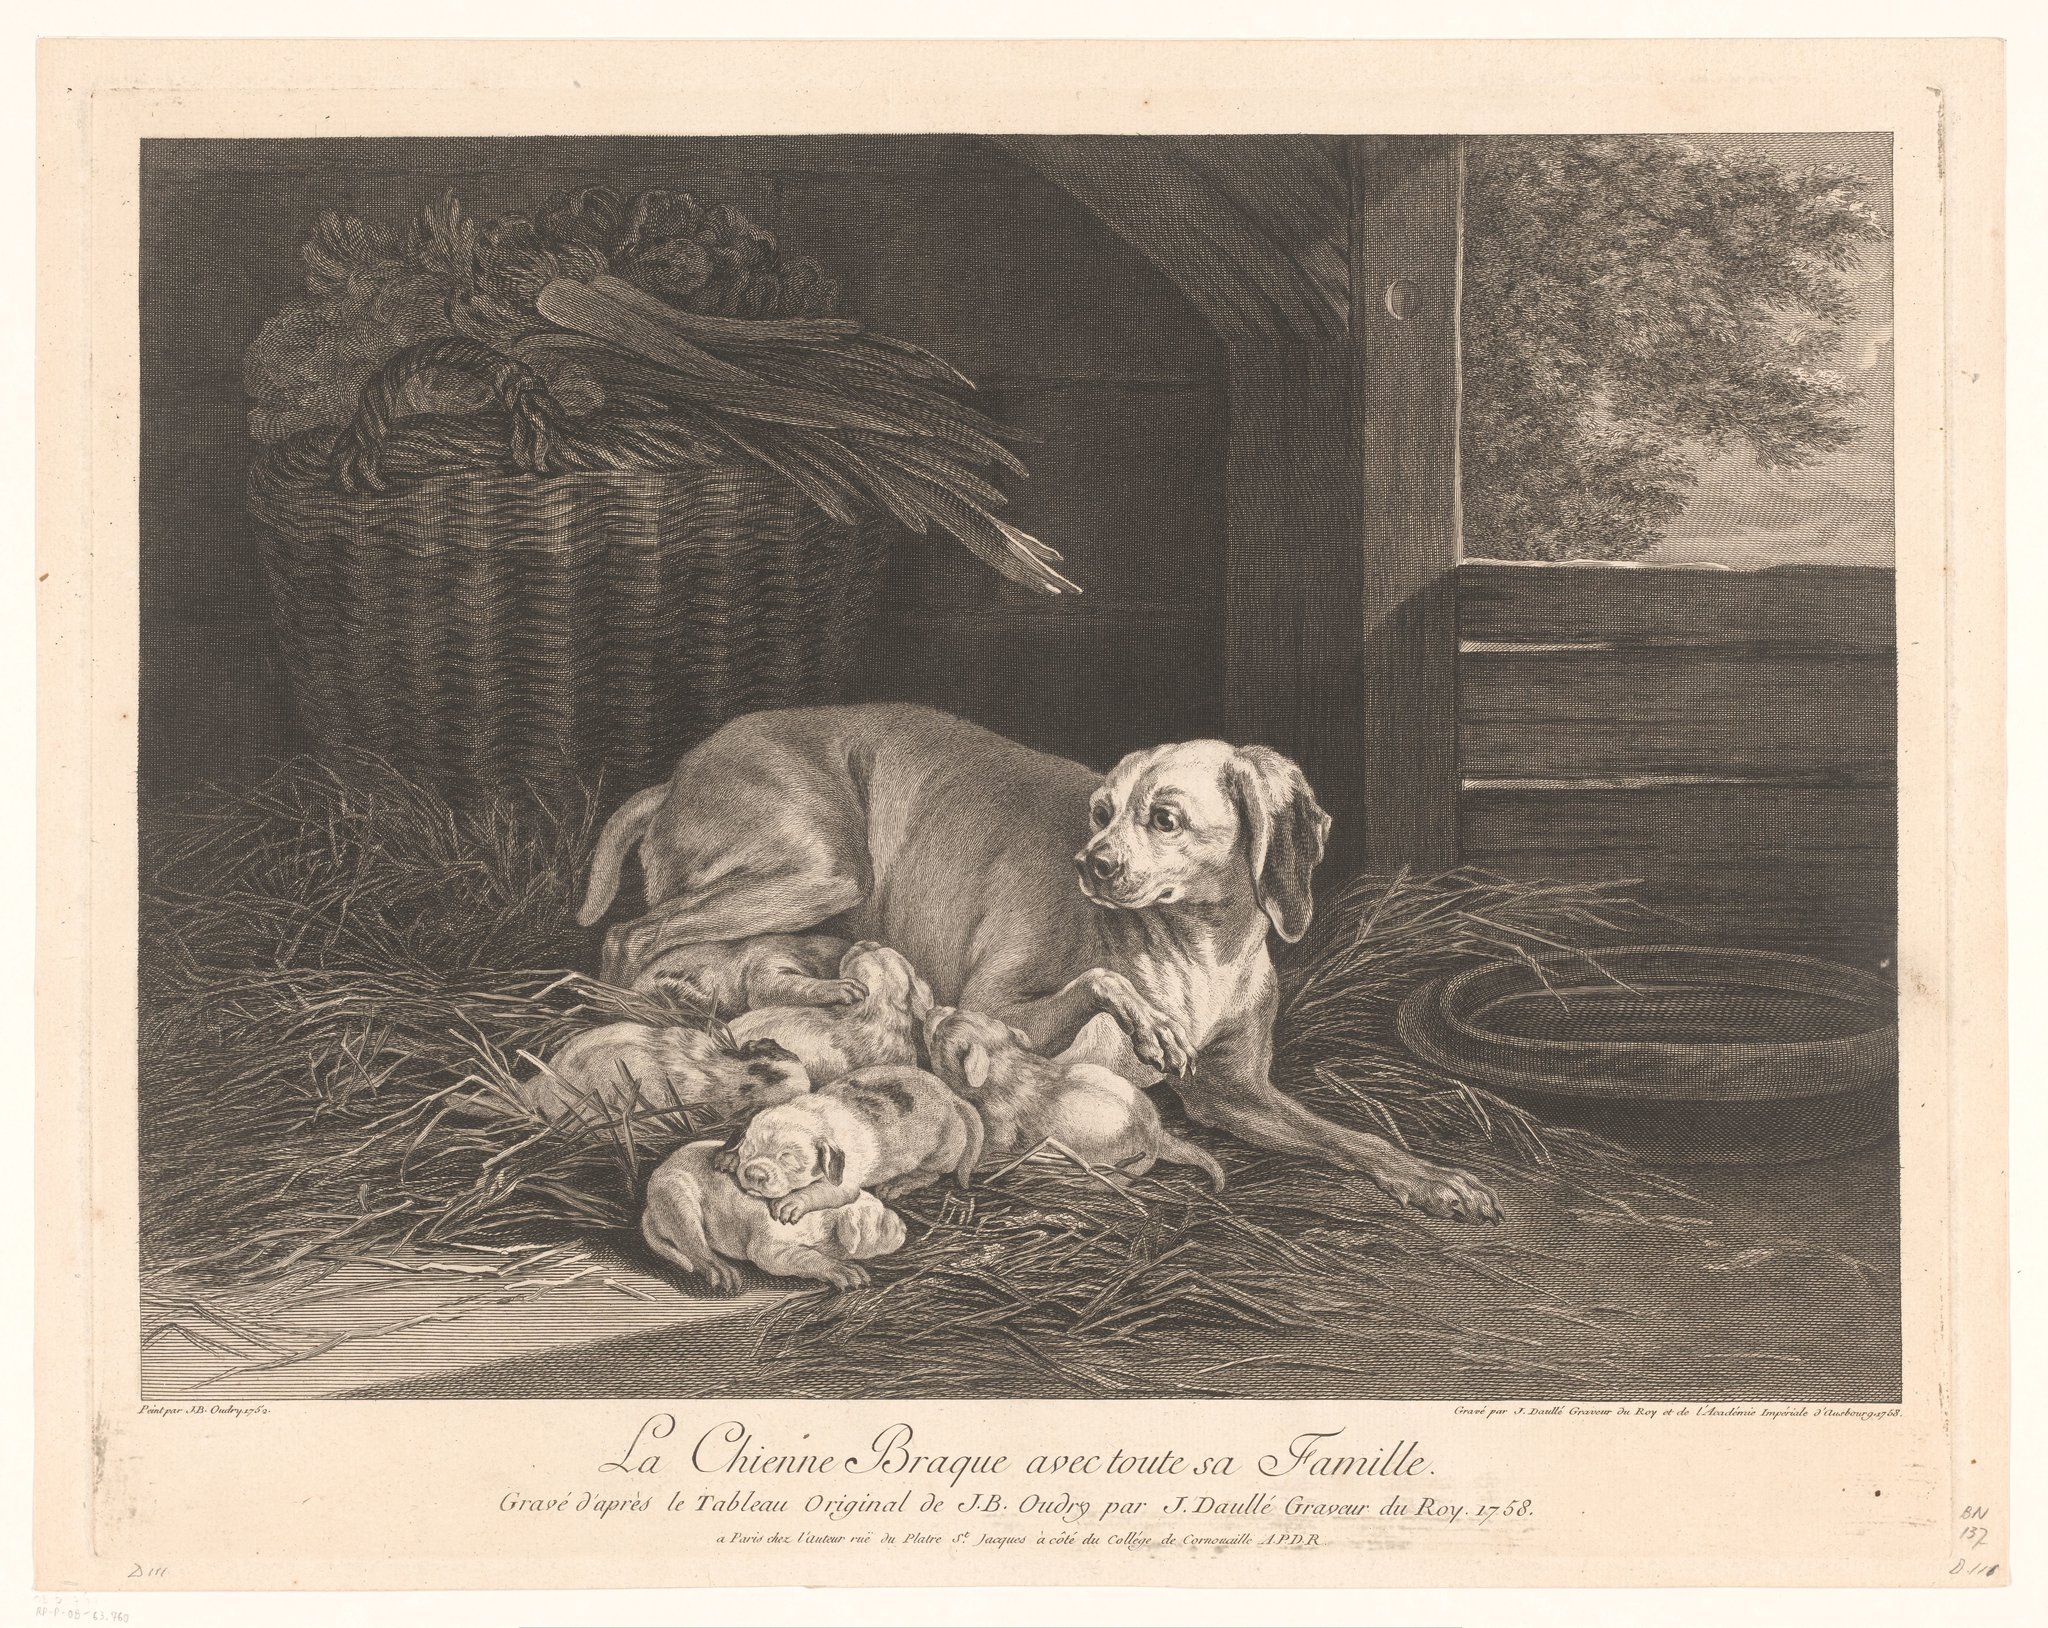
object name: print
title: La Chienne Braque avec toute sa Famille.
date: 1758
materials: paper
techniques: engraving, etching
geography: france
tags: hunting dogs, family, relationship, descent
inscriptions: collector's mark: Lugt 2228